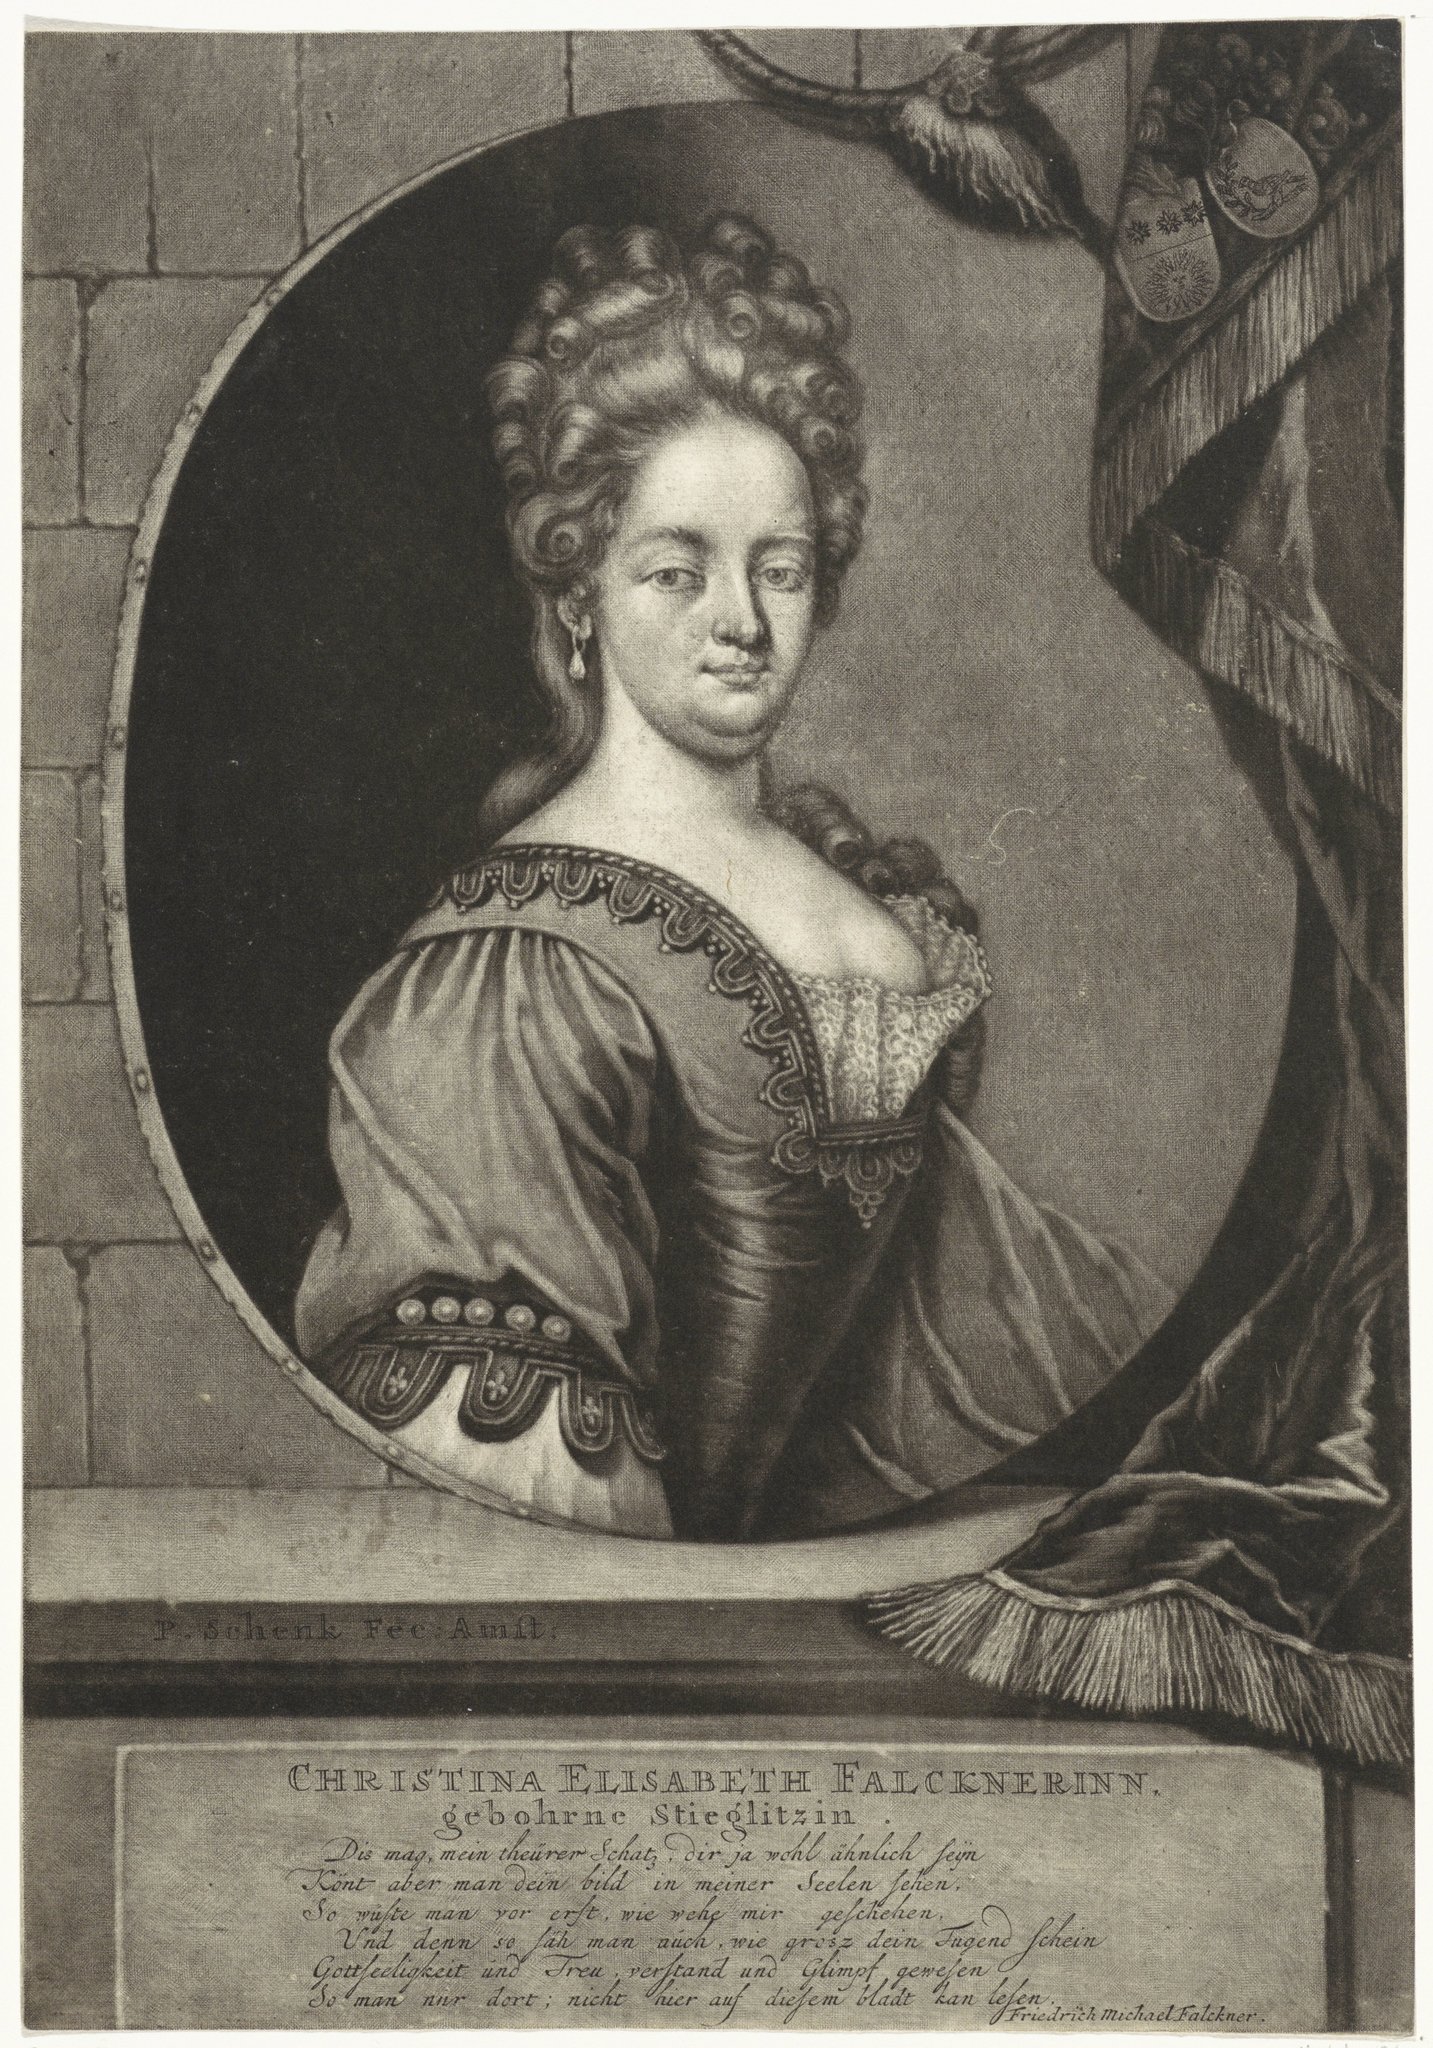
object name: print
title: Portret van Christina Elisabeth Falckner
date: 1670-1713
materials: paper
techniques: engraving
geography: amsterdam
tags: armorial bearing, heraldry, pearl; pearl necklace (+ women's clothes)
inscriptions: collector's mark: Lugt 2228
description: Christina Elisabeth Falckner, echtgenote van de jurist Friedrich Michael Falckner. In de marge een gedicht van haar man.